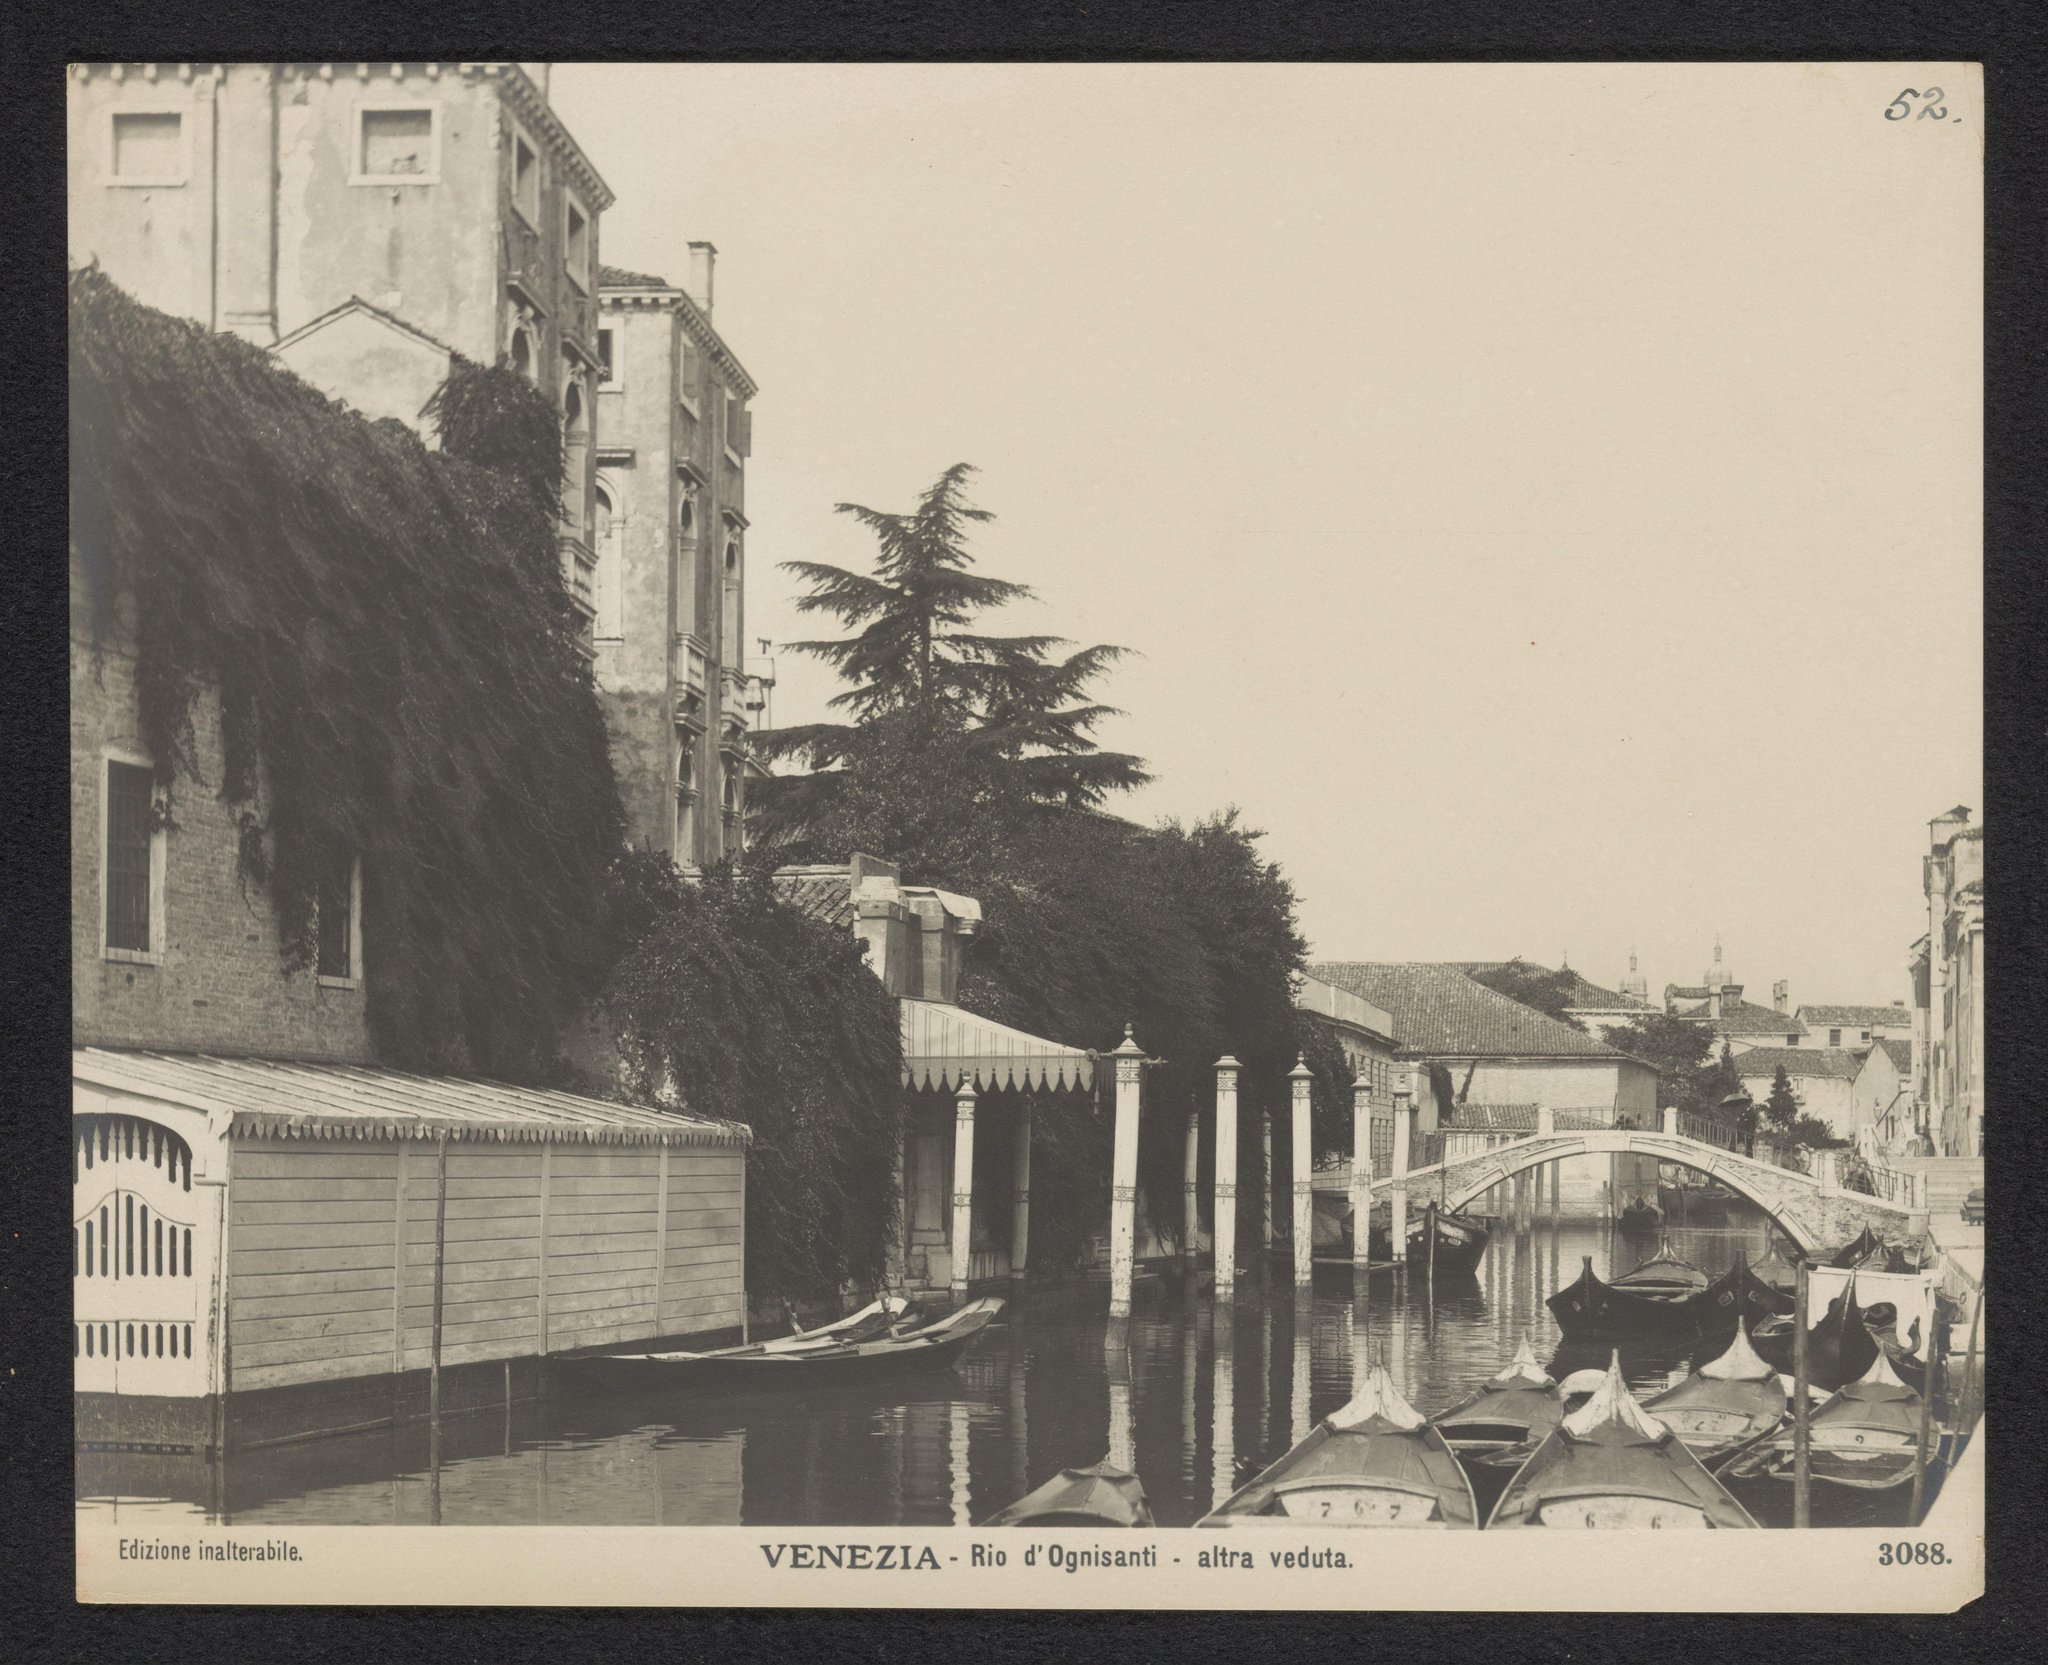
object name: photograph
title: Gezicht op de Rio dei Ognissanti te Venetië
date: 1900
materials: cardboard, photographic support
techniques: gelatin silver print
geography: venice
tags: canal, gondola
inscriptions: number: ‘52.’, number: ‘3088.’